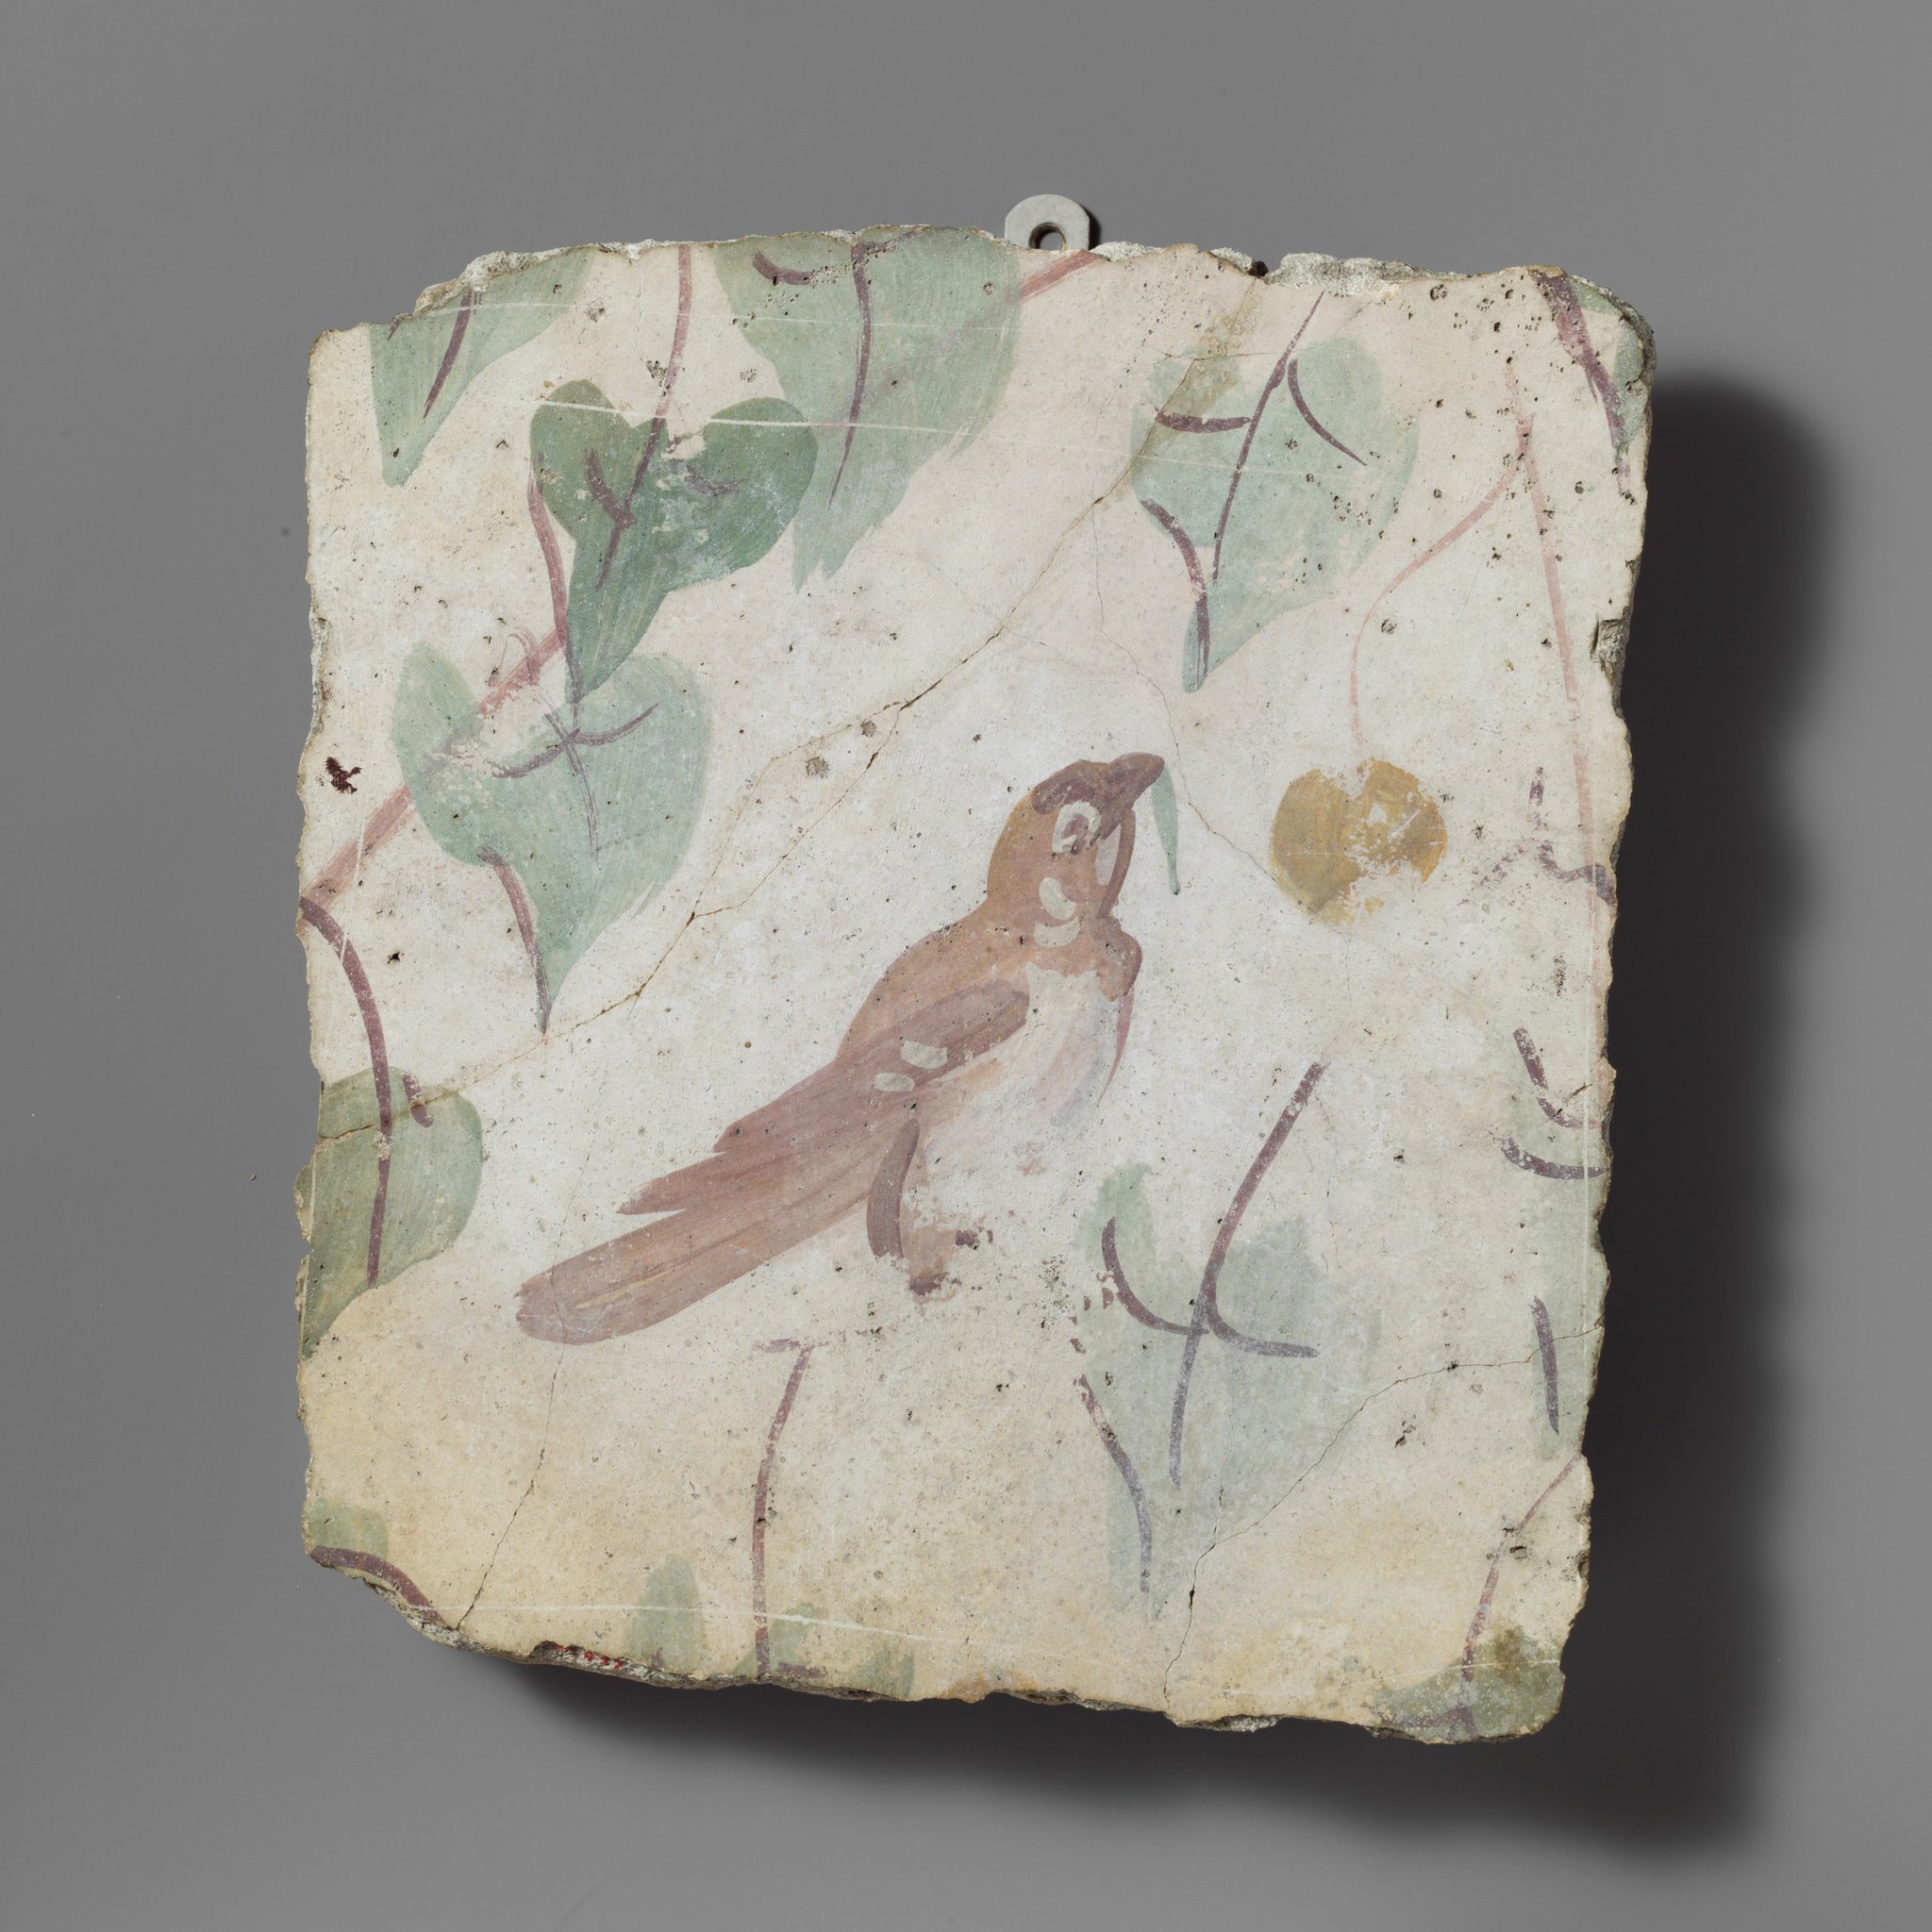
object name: wall painting fragment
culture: roman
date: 101-300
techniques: fresco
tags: birds